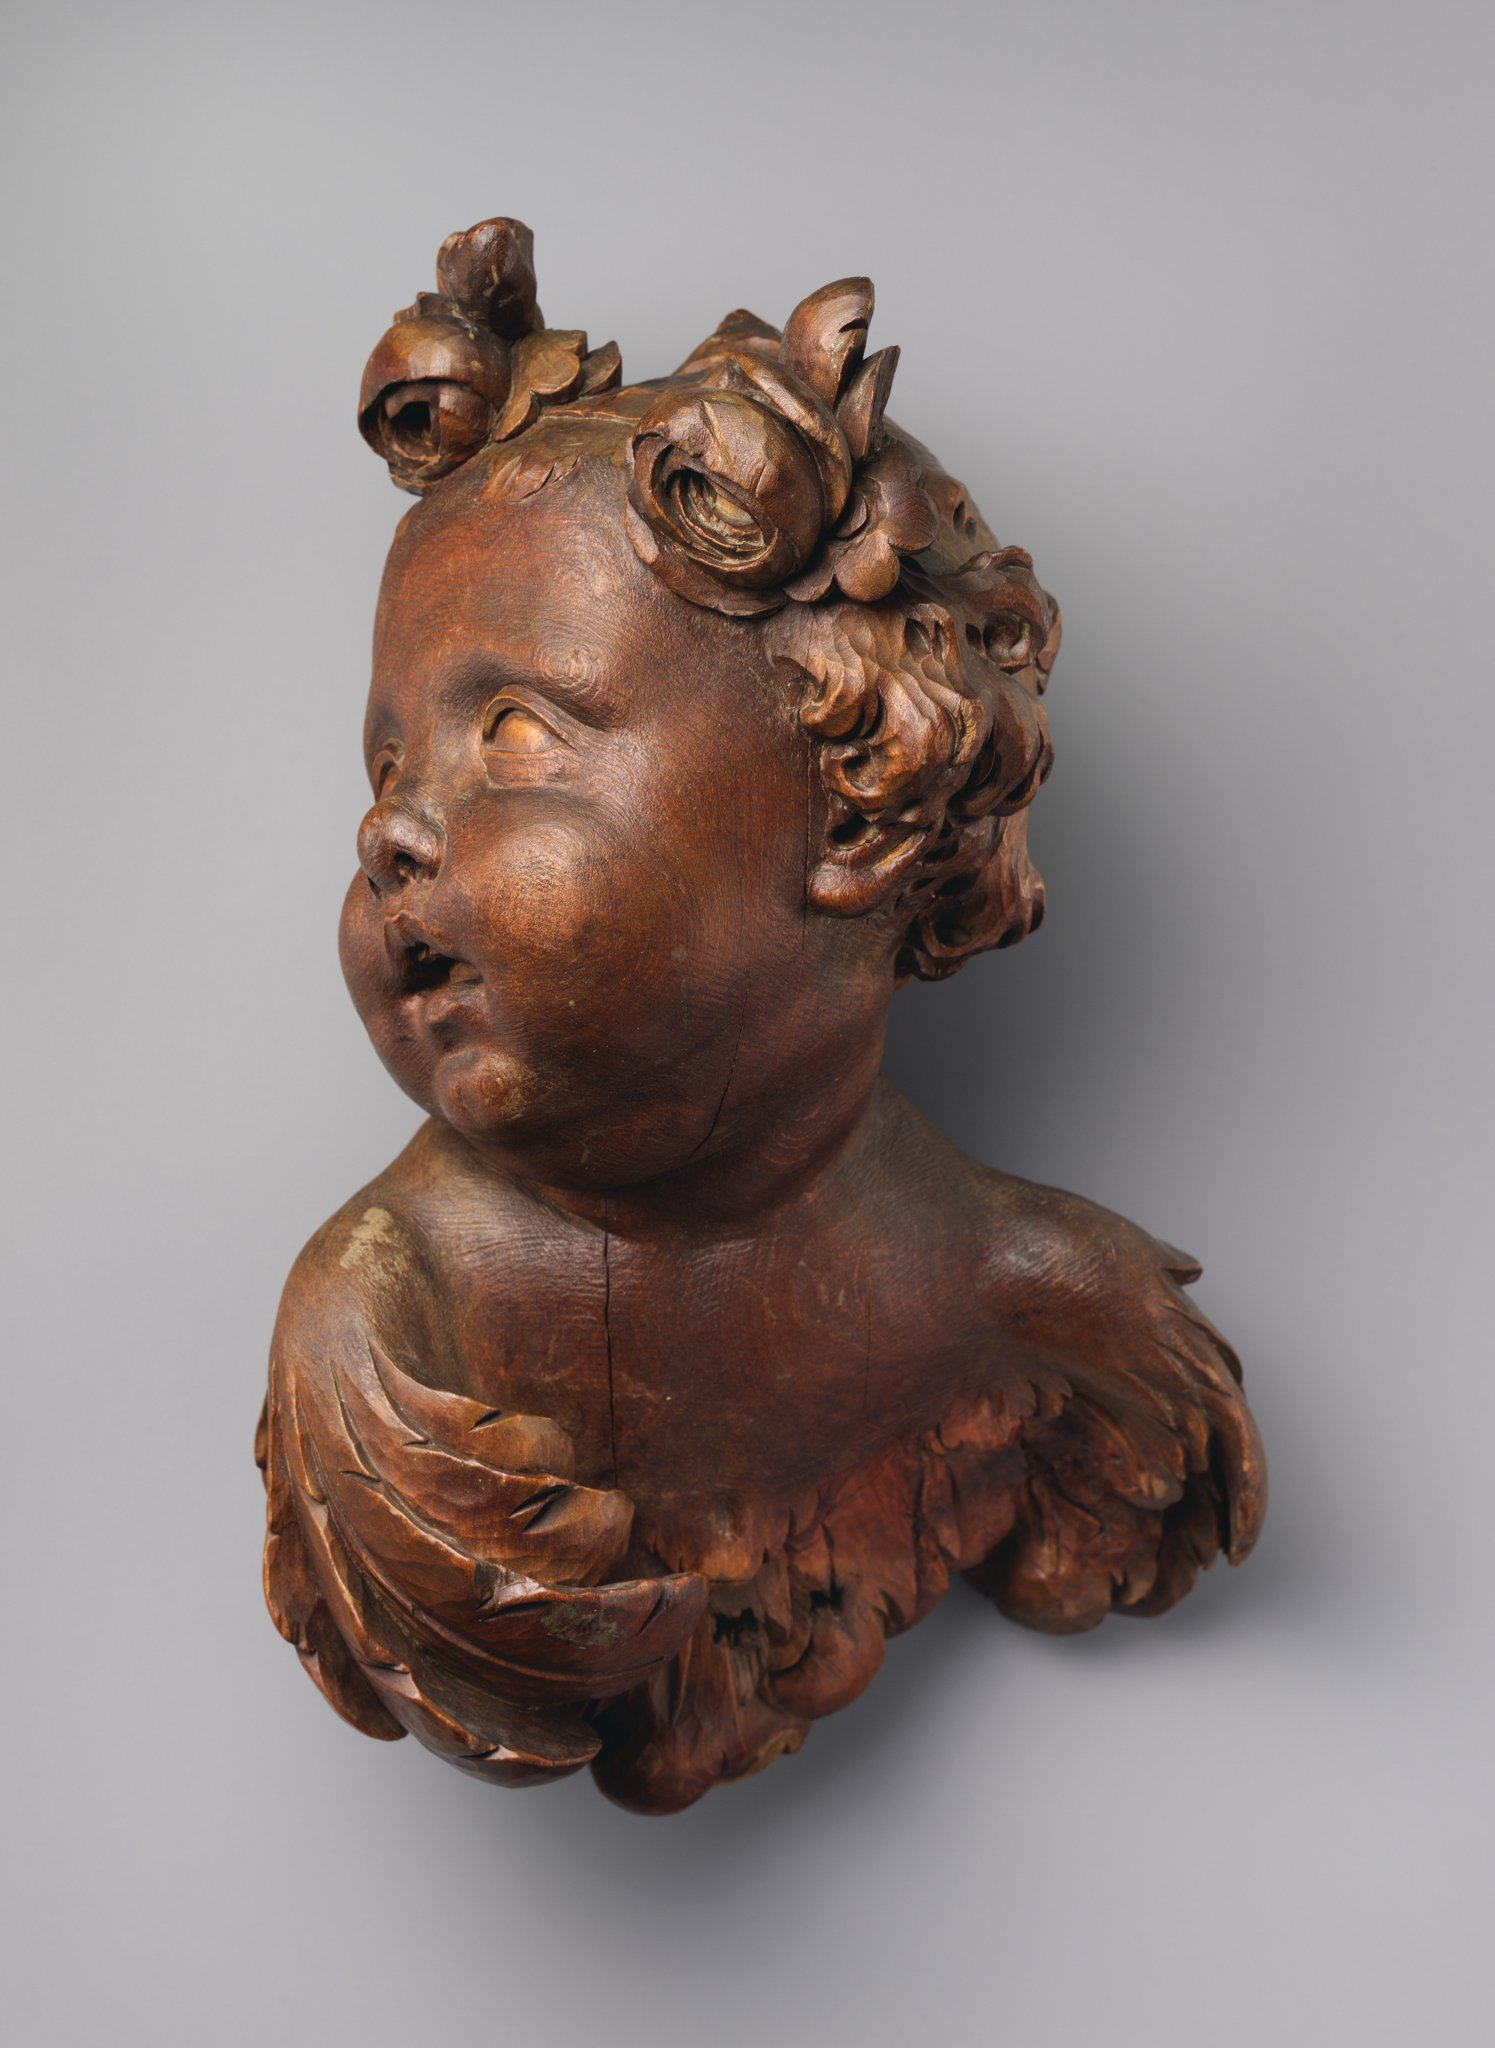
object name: head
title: Angel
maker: ignaz günther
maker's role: artist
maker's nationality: german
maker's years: 1725-1775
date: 1760-1770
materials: gesso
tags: angels